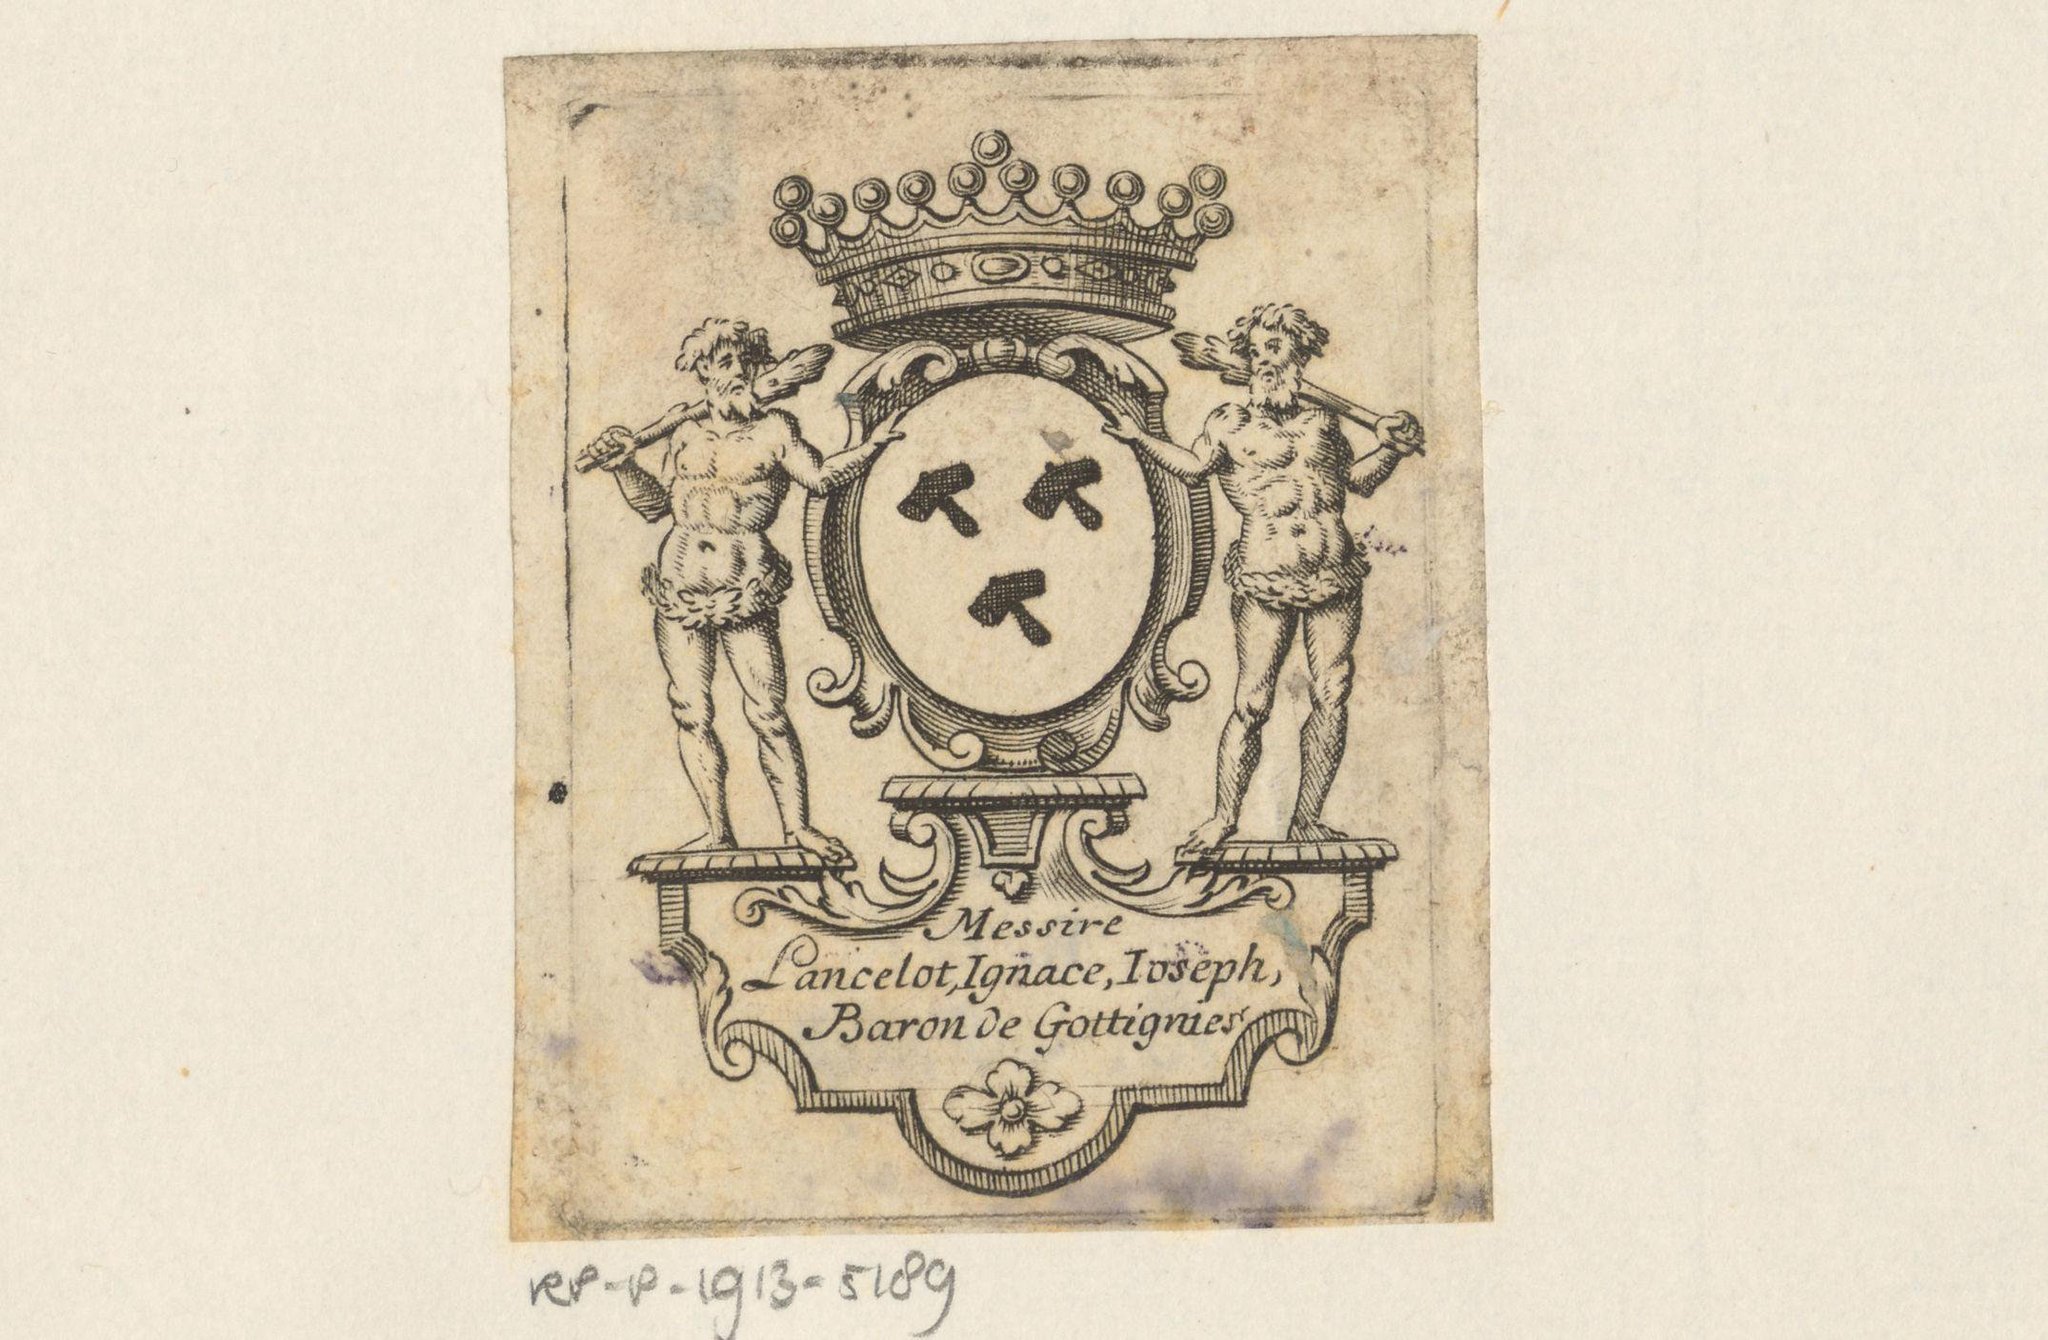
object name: bookplate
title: Messire Lancelot Ignace Ioseph Baron de Gottignies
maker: Anonymous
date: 1700-1786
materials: paper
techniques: engraving, etching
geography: belgium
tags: brussels, weapons for striking a blow: club, armorial bearing, heraldry, man (showing himself) undressed, quasi-nude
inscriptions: collector's mark: Lugt 2233, collector's mark: Lugt 2760